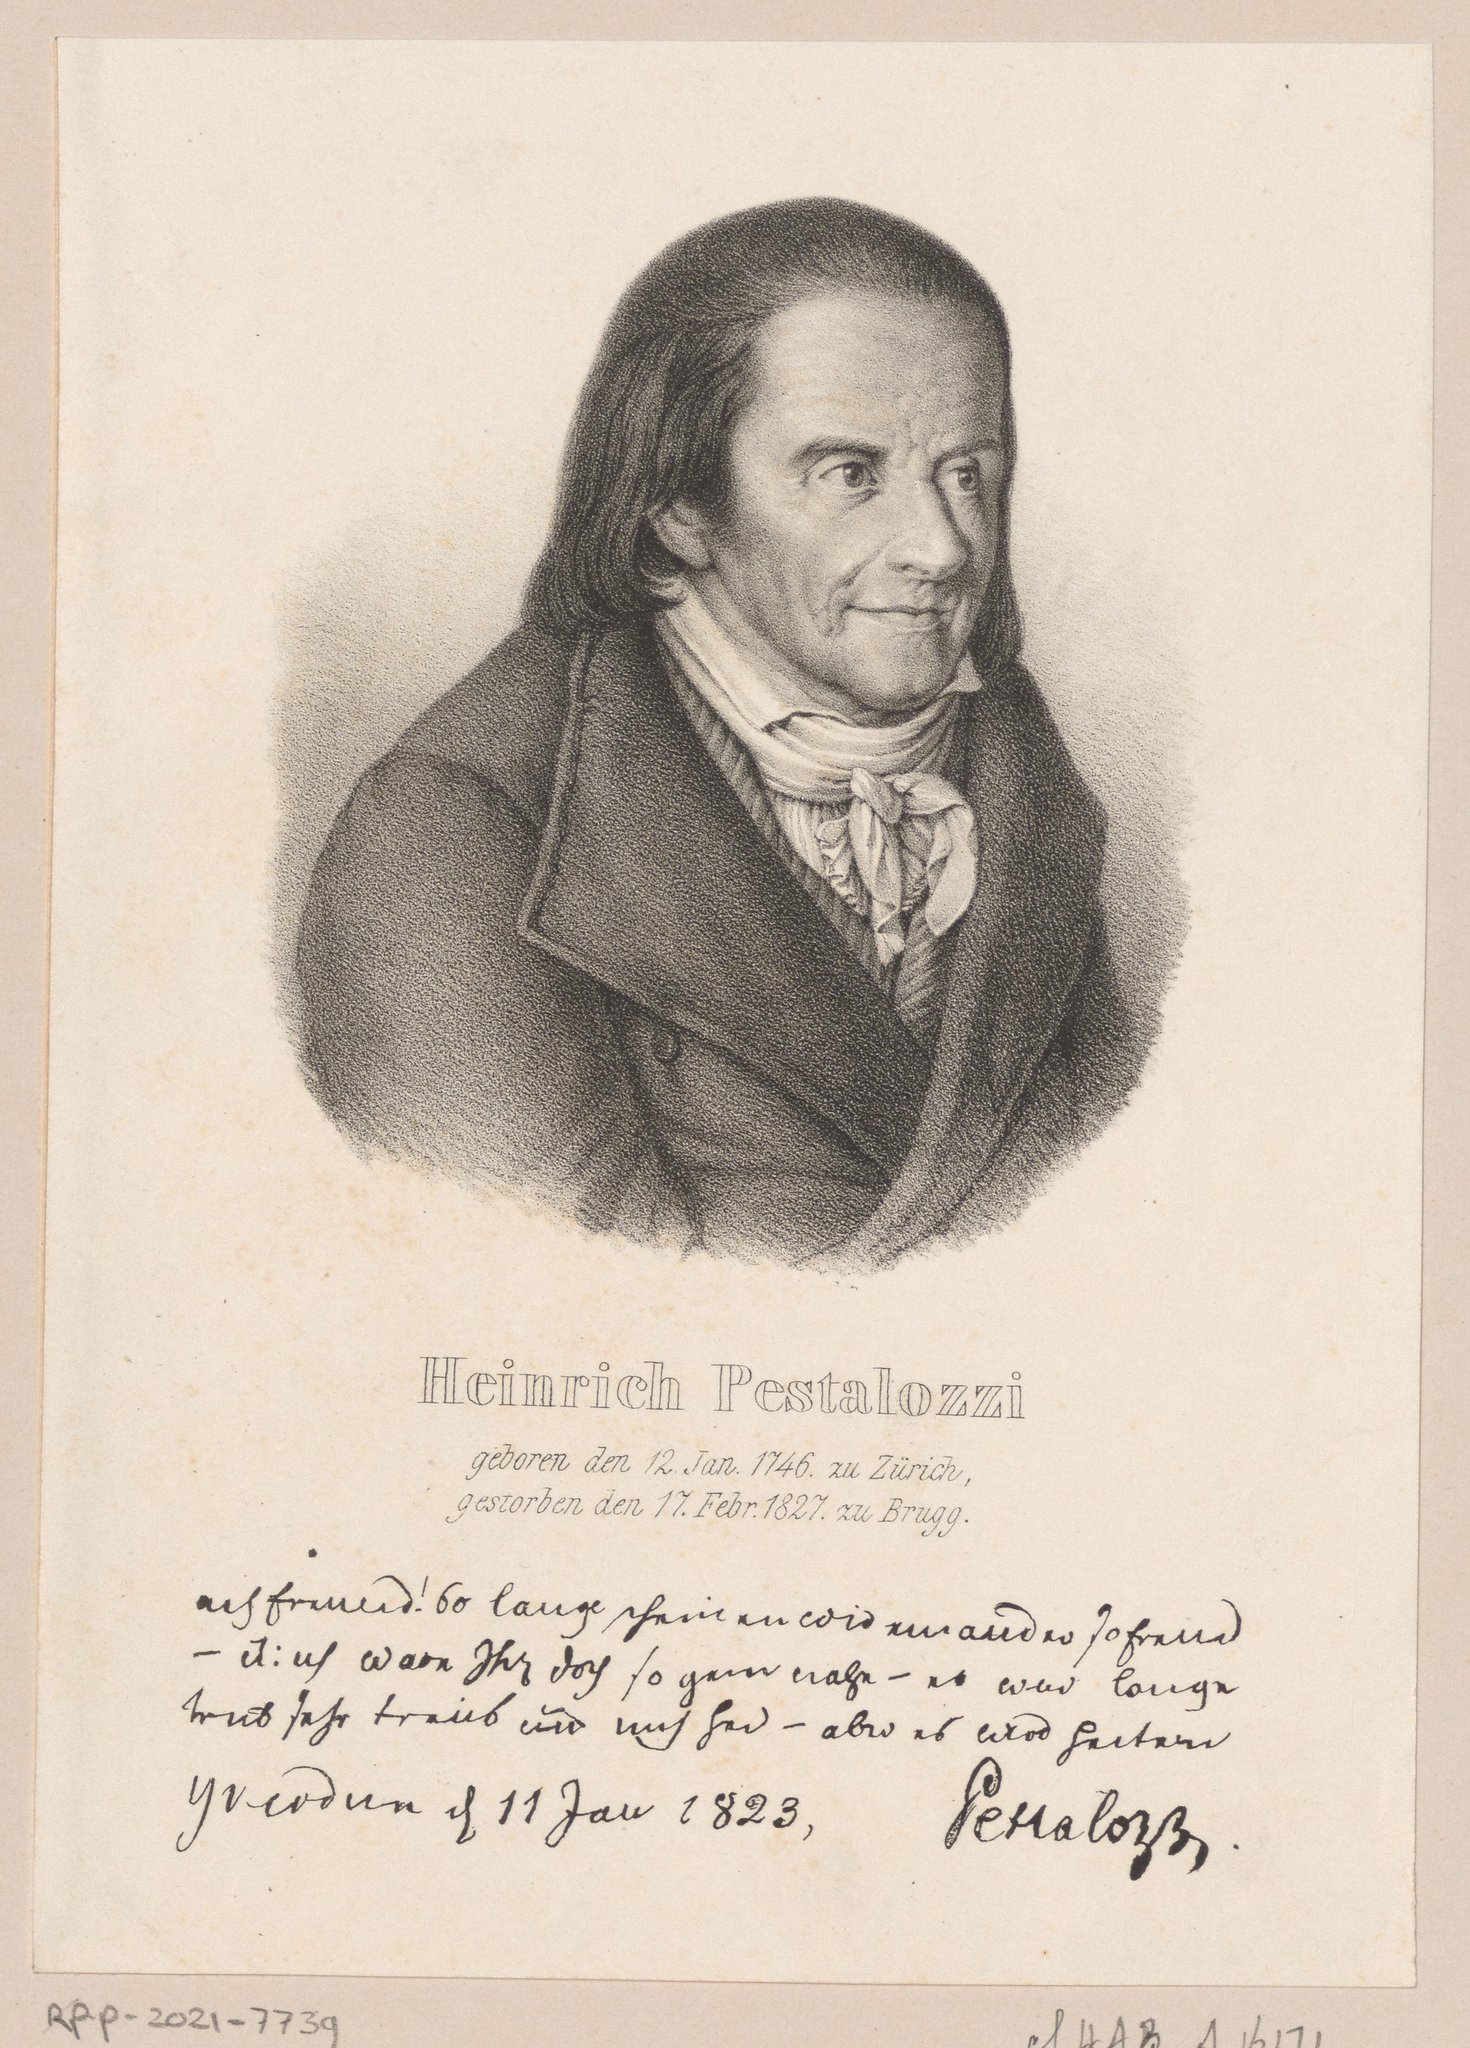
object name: print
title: Portret van Johann Heinrich Pestalozzi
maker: Anonymous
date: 1827-1849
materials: paper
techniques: lithograph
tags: politician, adult man, historical persons